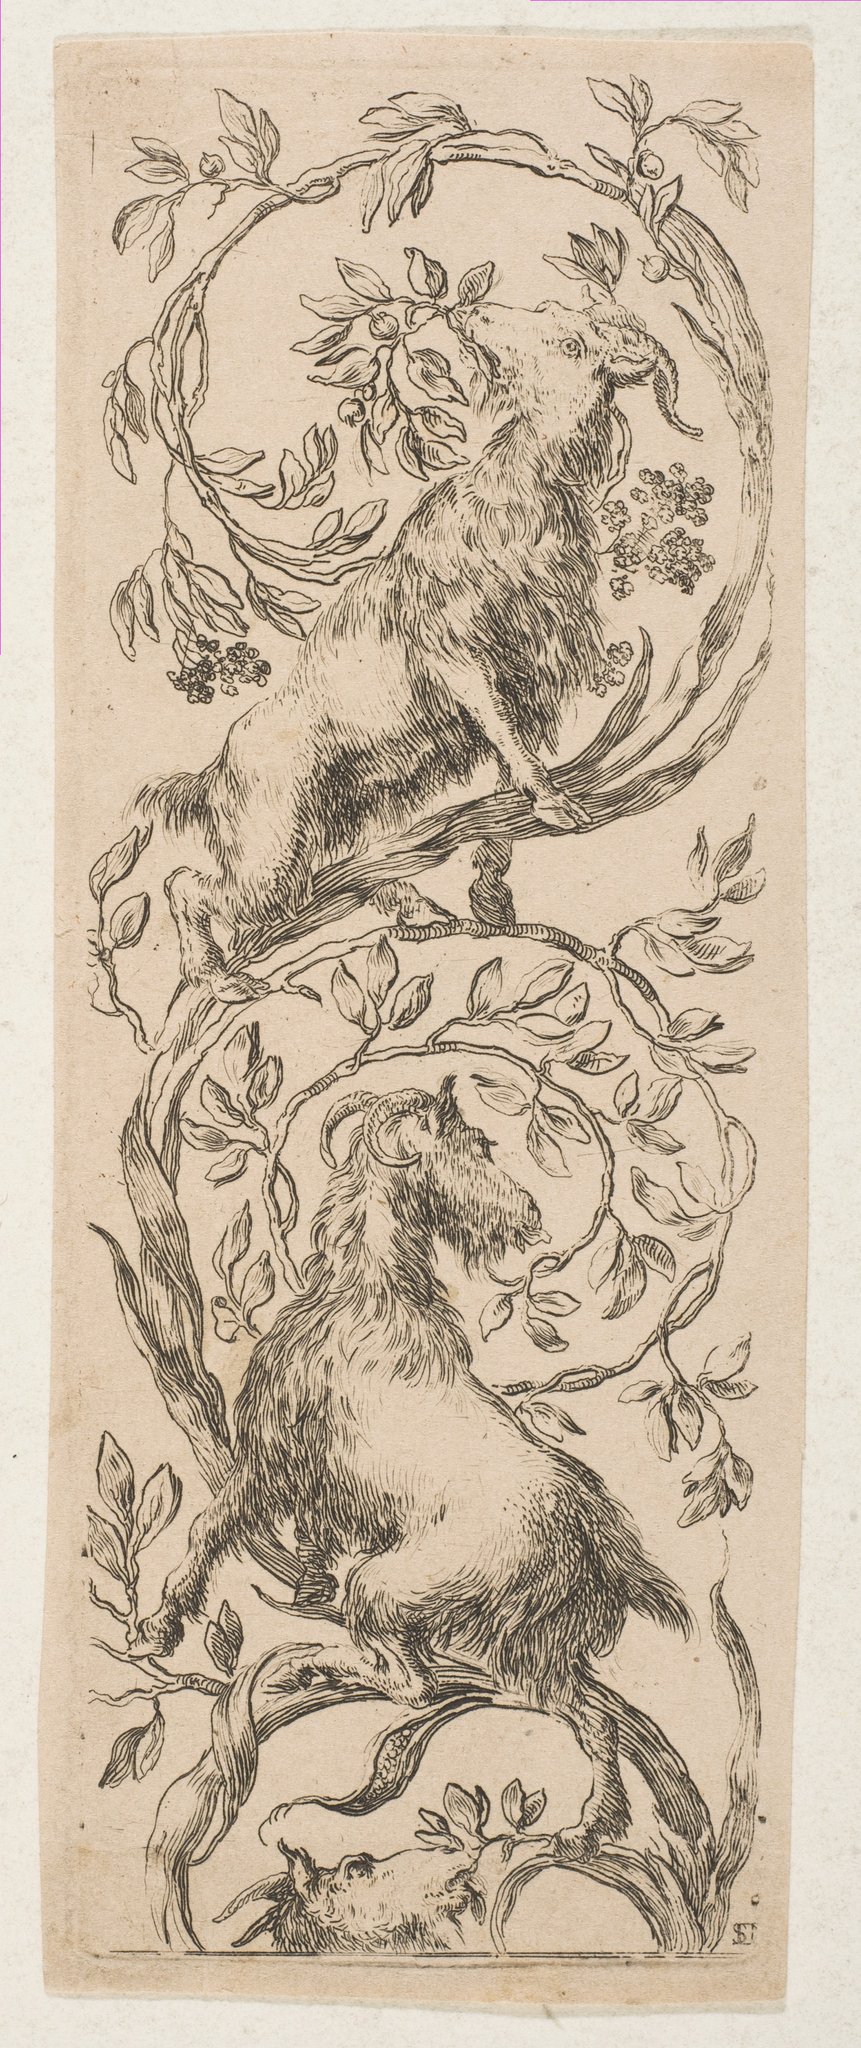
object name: print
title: Two Goats Nibbling Branches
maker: stefano della bella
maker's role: artist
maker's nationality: italian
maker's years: 1610-1664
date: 1653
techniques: etching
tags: goats,leaves